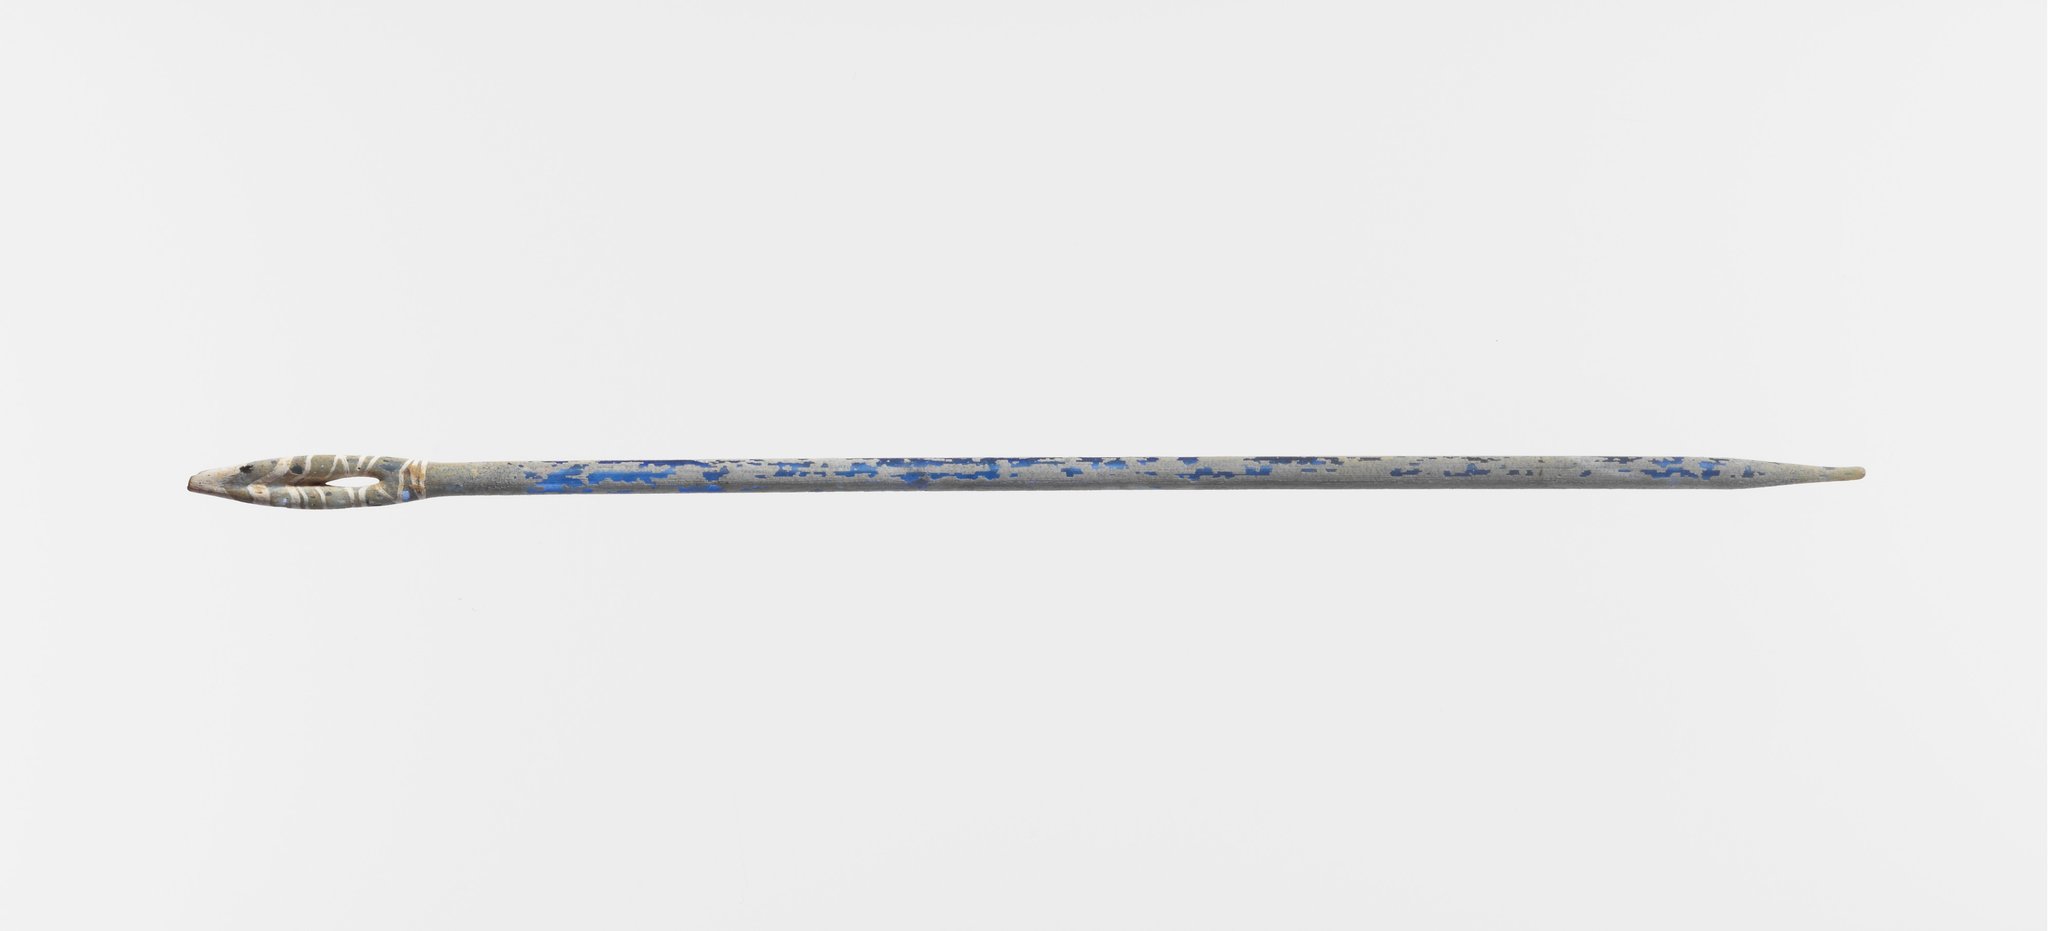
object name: needle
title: Glass needle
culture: roman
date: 1-100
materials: glass